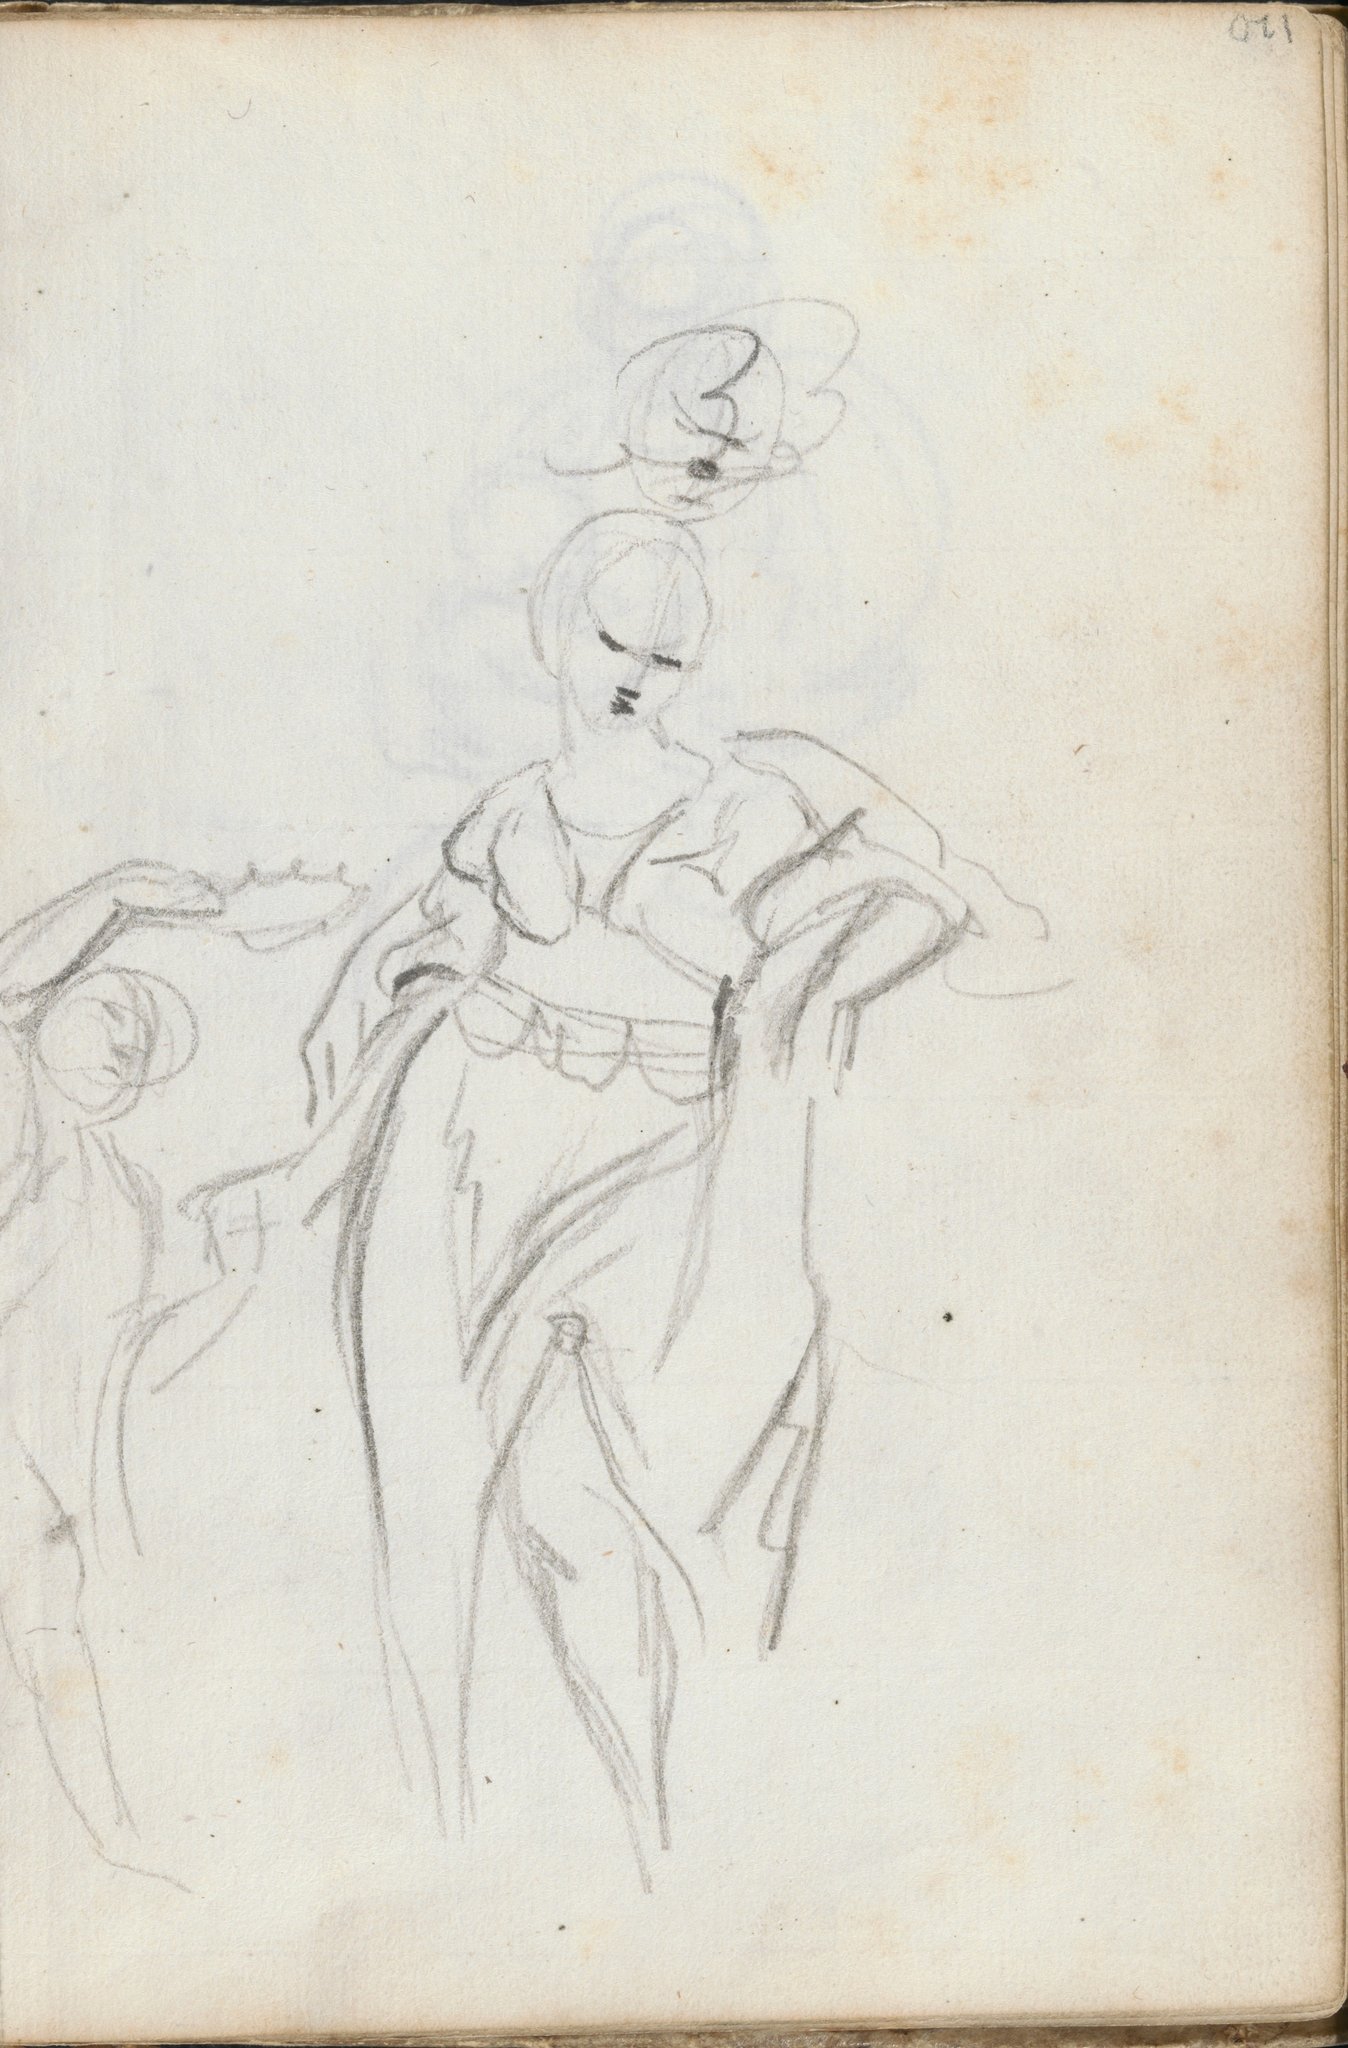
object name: sketchbook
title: Diana (leaf in Italian Sketch Book, 1750–52)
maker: sir joshua reynolds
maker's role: artist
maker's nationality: british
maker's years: 1723-1792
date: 1750-1752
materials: graphite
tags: diana